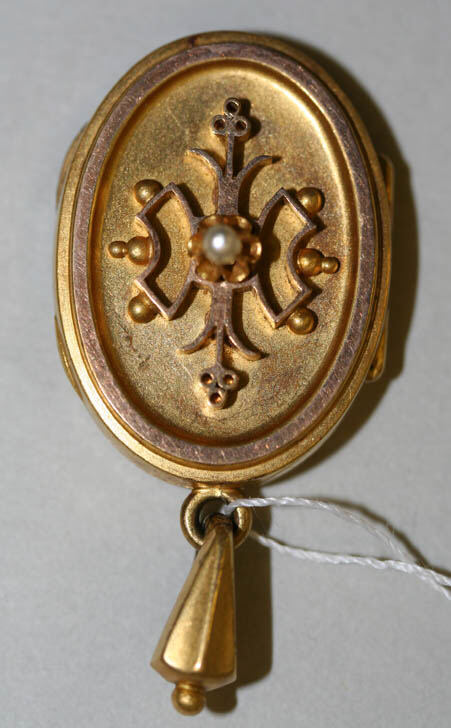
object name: locket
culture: american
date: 1875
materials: metal, pearl